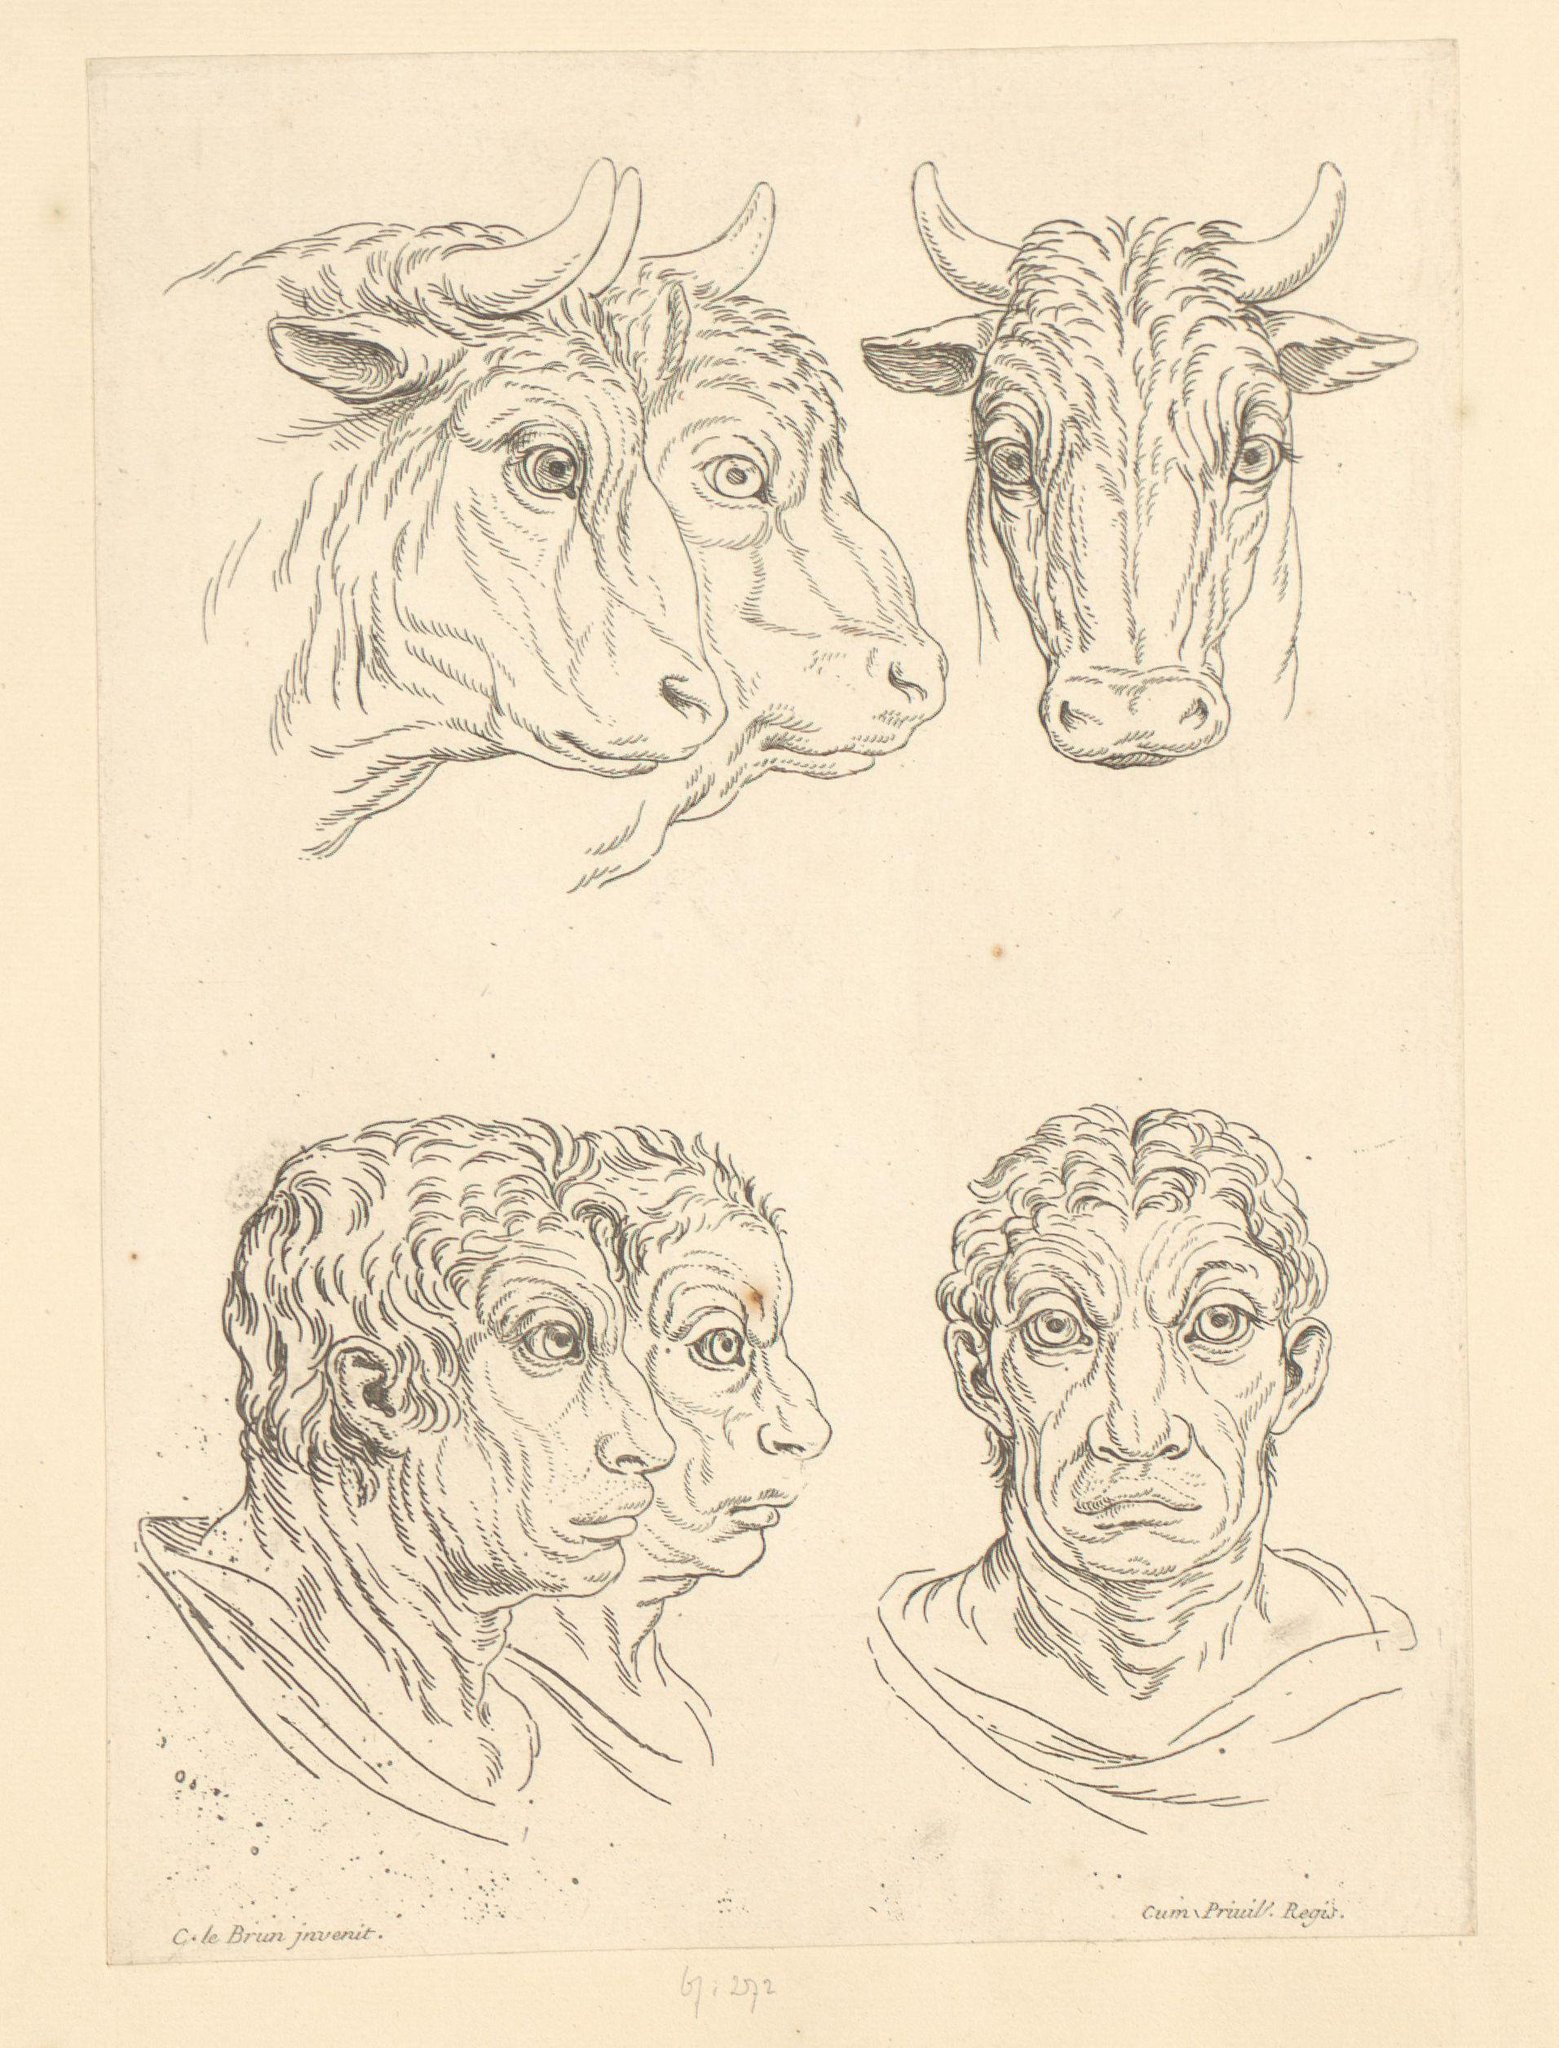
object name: print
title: L'ouvrage de Charles le Brun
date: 1700-1725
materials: paper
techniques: etching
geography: paris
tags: face, bovine cattle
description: Deze prent maakt deel uit van de serie 'Livre de portraiture', die weer onderdeel is van de grotere reeks 'Oeuvre de Charles le Brun'.